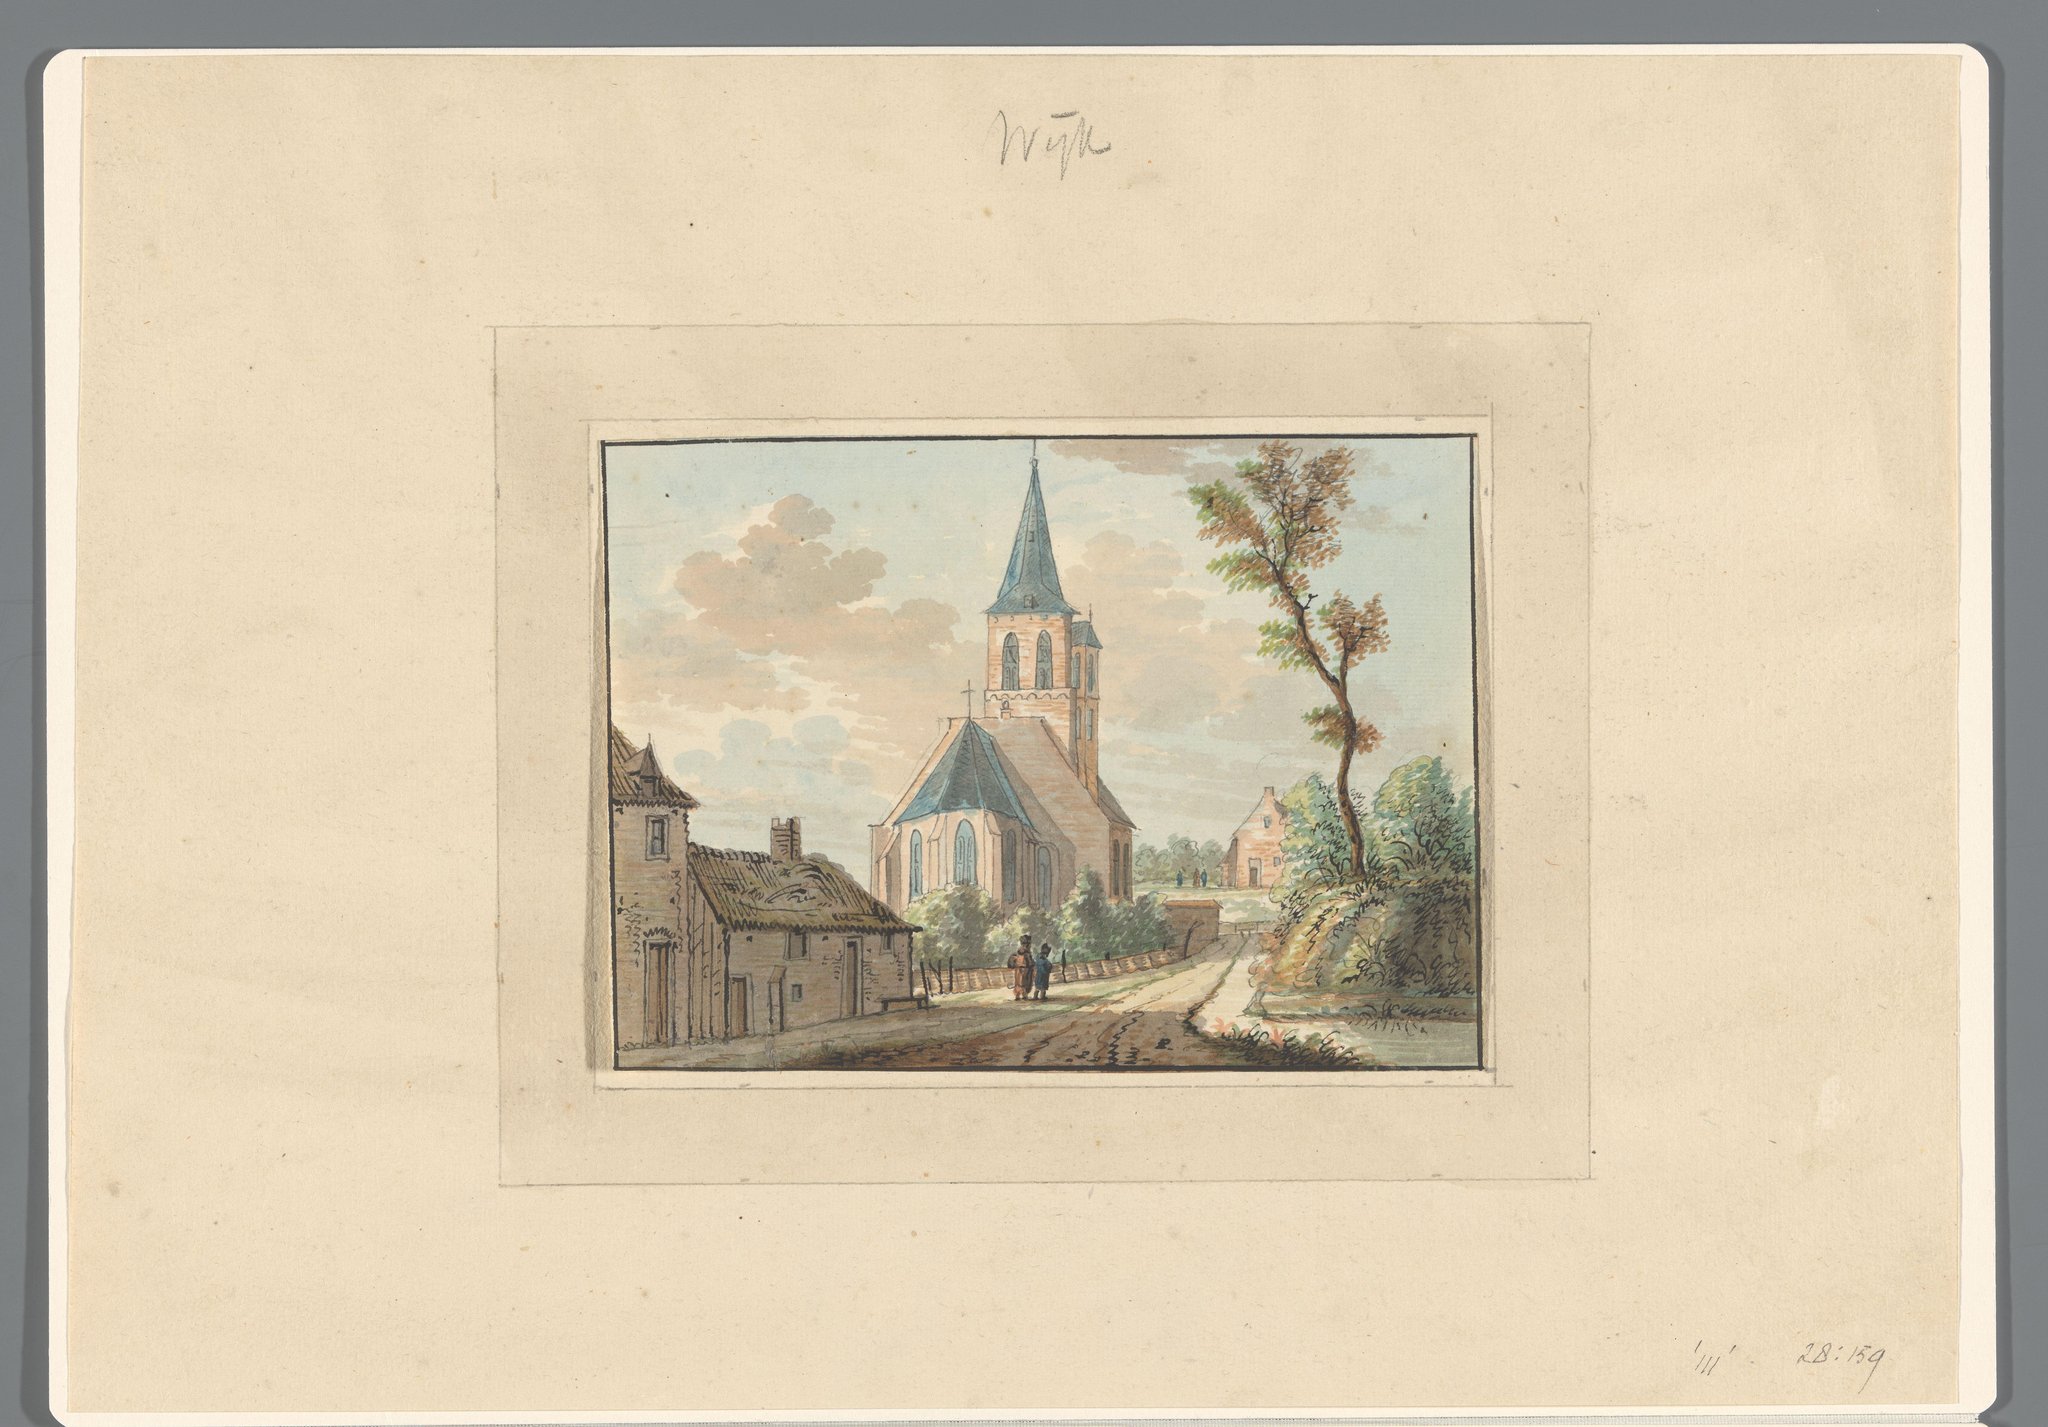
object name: drawing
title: Gezicht te Wijk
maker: Anonymous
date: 1700-1800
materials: ink, paper, pencil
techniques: brush, pen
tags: church (exterior)